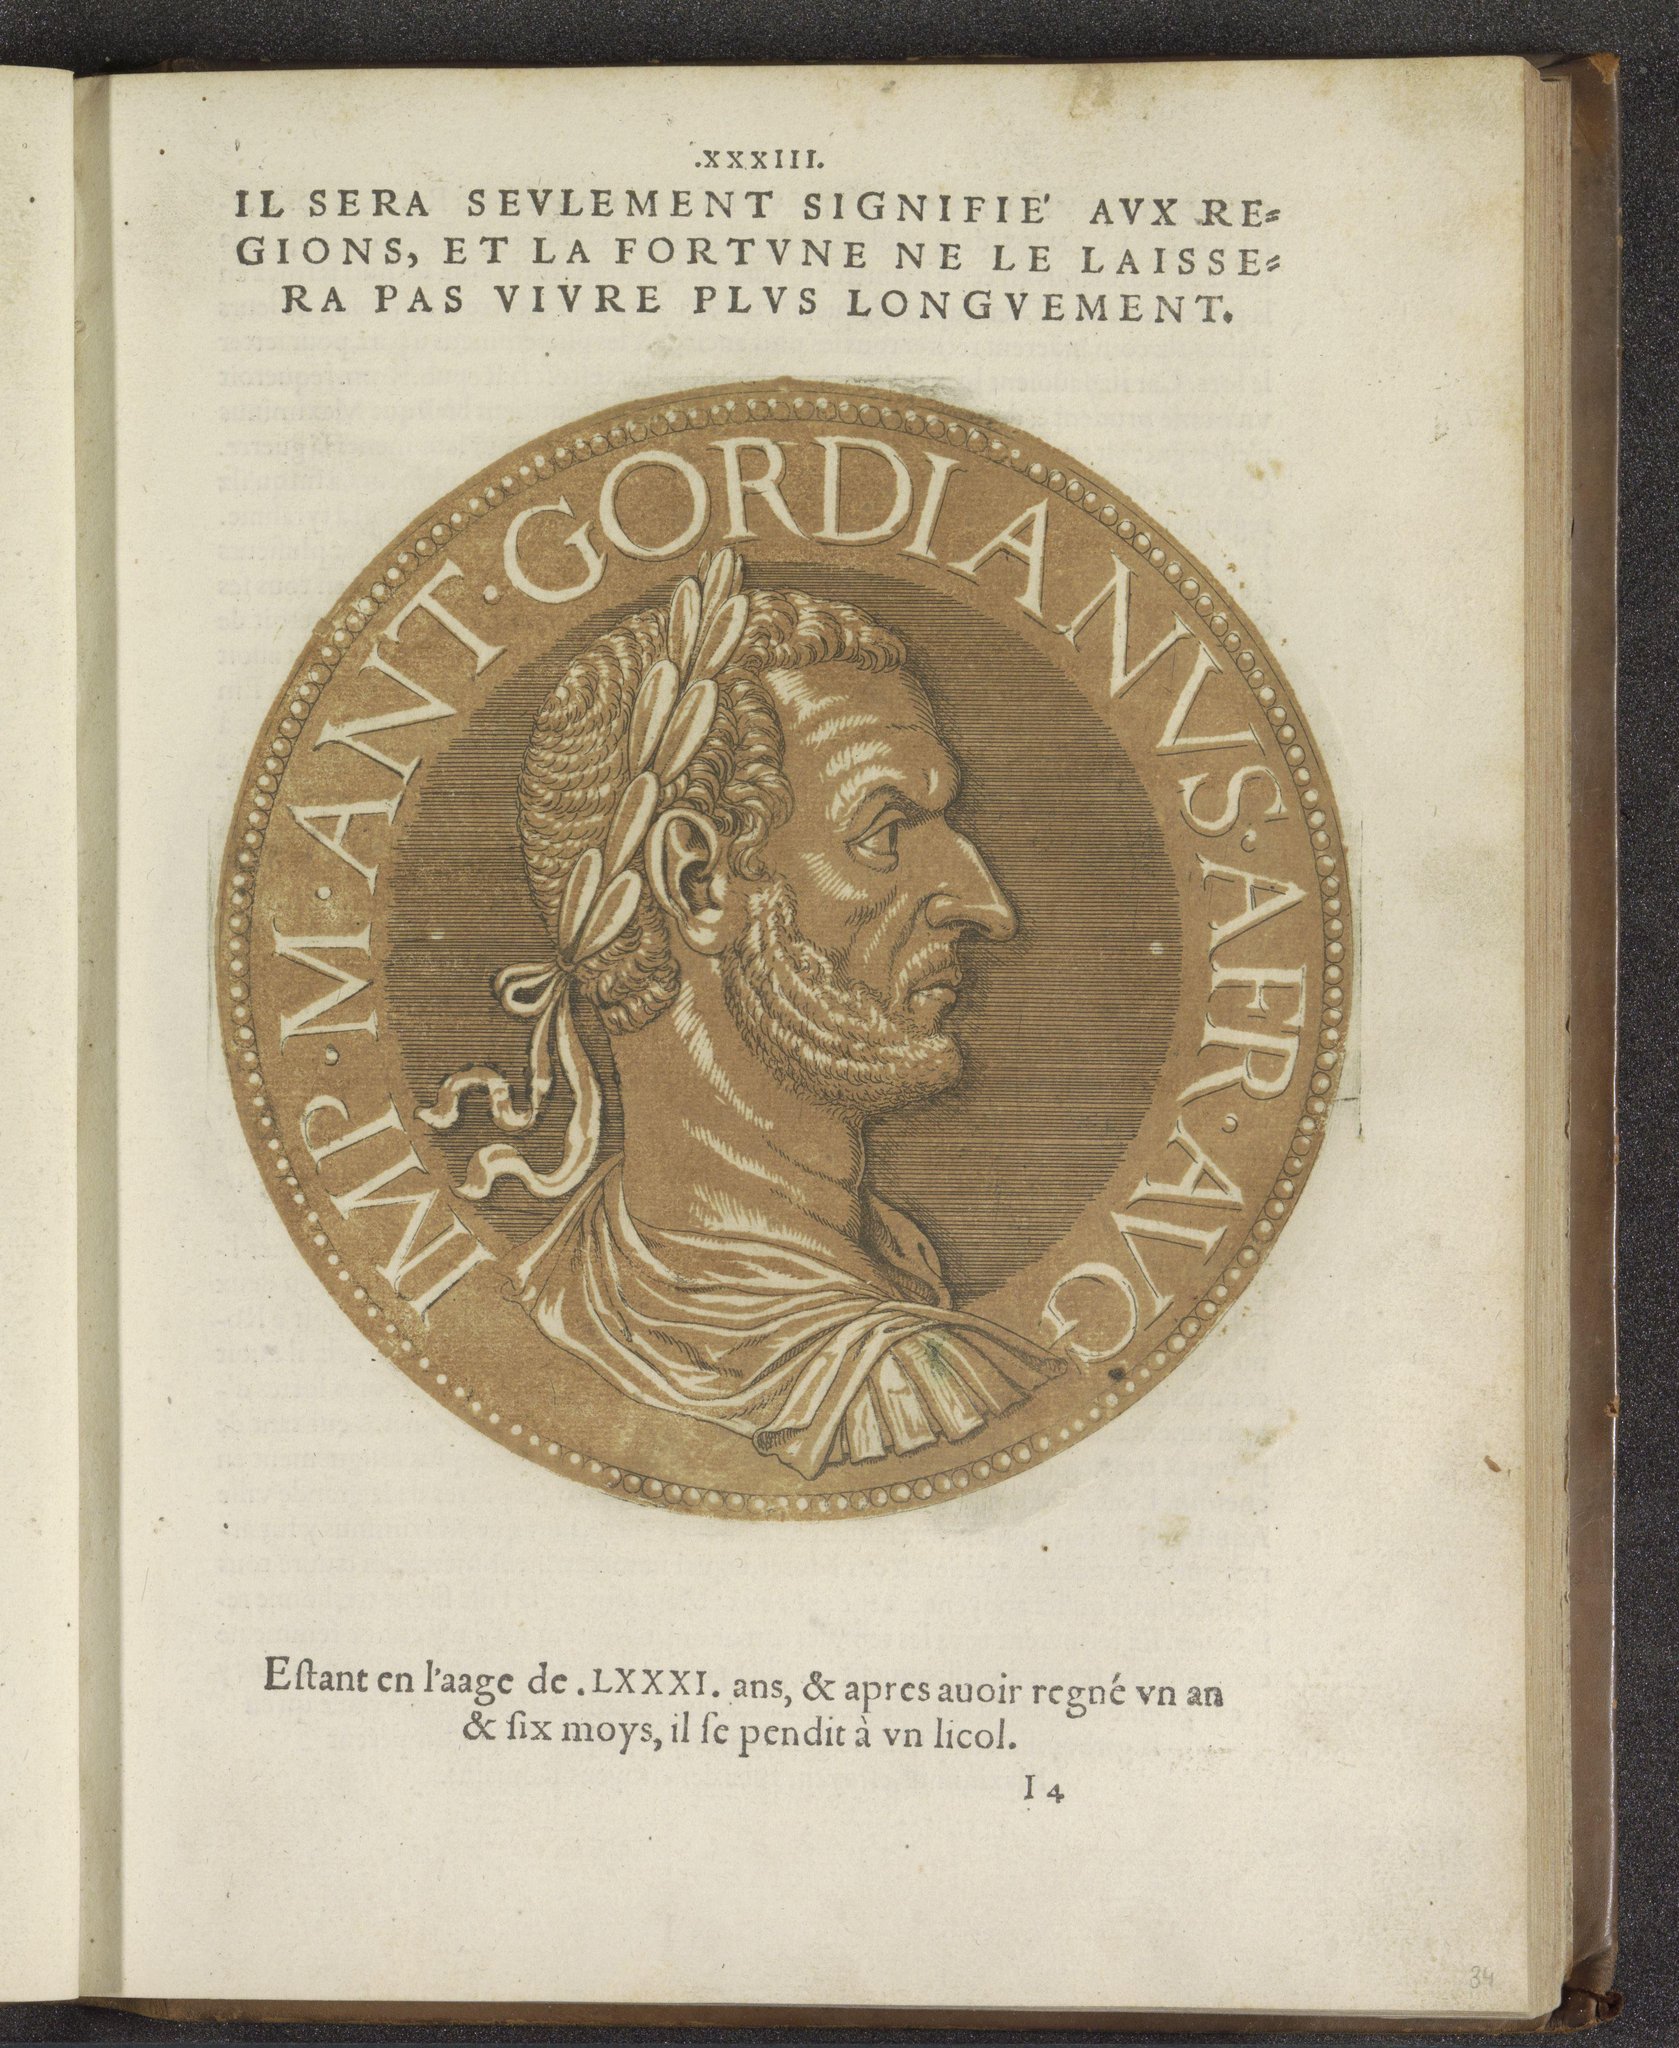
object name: print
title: Les images presque de tous les empereurs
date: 1557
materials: paper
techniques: woodcut, etching, letterpress printing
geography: antwerp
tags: emperor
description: Portret van keizer Gordianus I, op een munt met randschrift. De prent maakt deel uit van een boek over de keizers vanaf Julius Caesar tot en met Karel V en zijn broer Ferdinand.